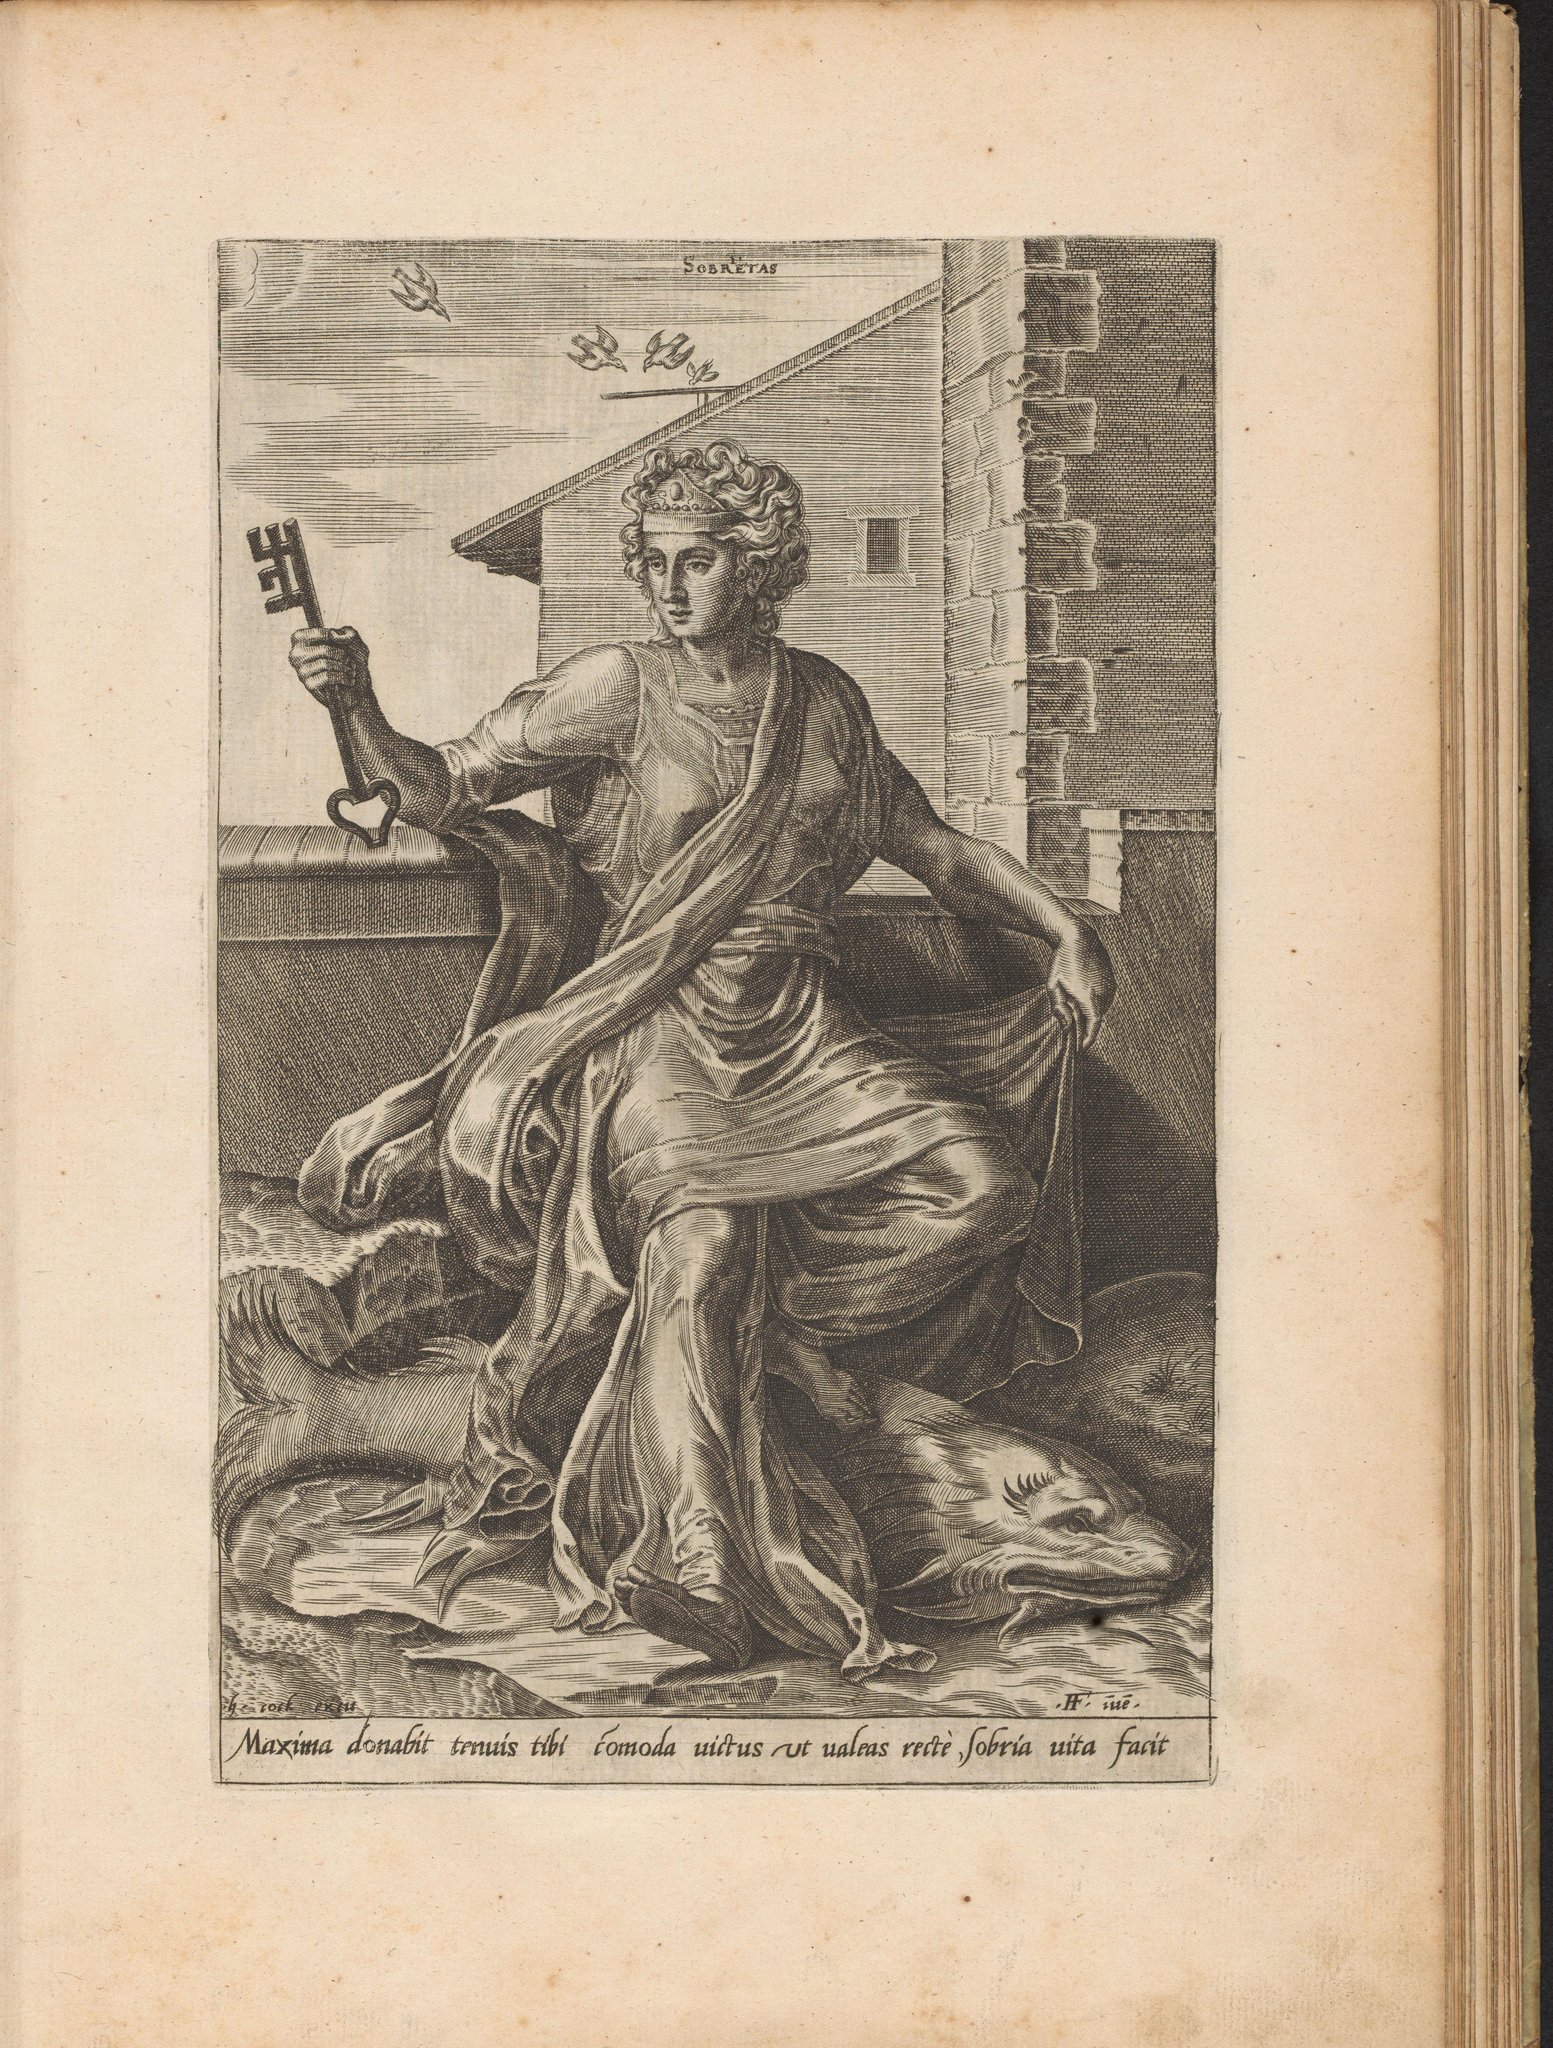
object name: print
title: Sobrietas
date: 1560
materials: paper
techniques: engraving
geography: antwerp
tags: sobriety; 'sobrietà', 'astinenza' (ripa)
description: De personificatie van de Soberheid zit voor een muur, haar benen op een vis. In haar haar draagt ze een diadeem, in haar hand houdt ze een grote sleutel. De sleutel staat symbool voor het goede huishouden. Op de achtergrond duiven die naar een duiventil vliegen. Deze prent maakt deel uit van een album.